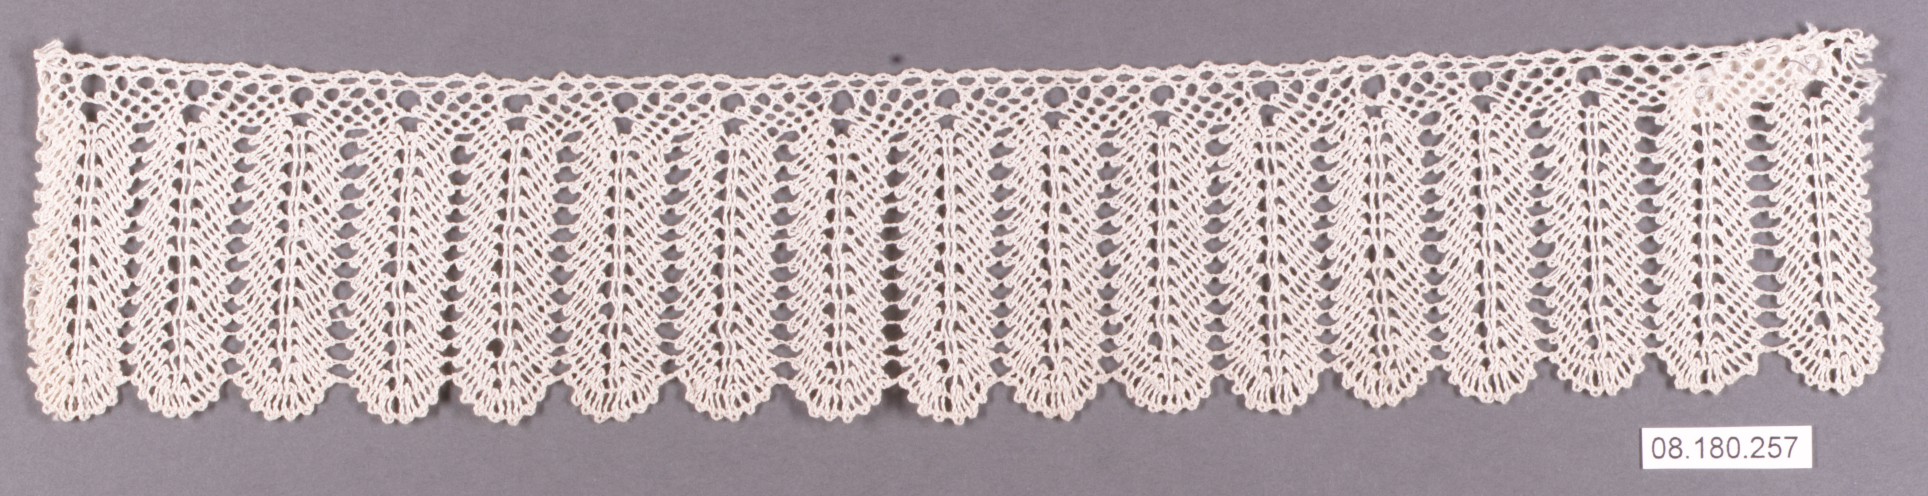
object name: fragment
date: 1801-1900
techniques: lace